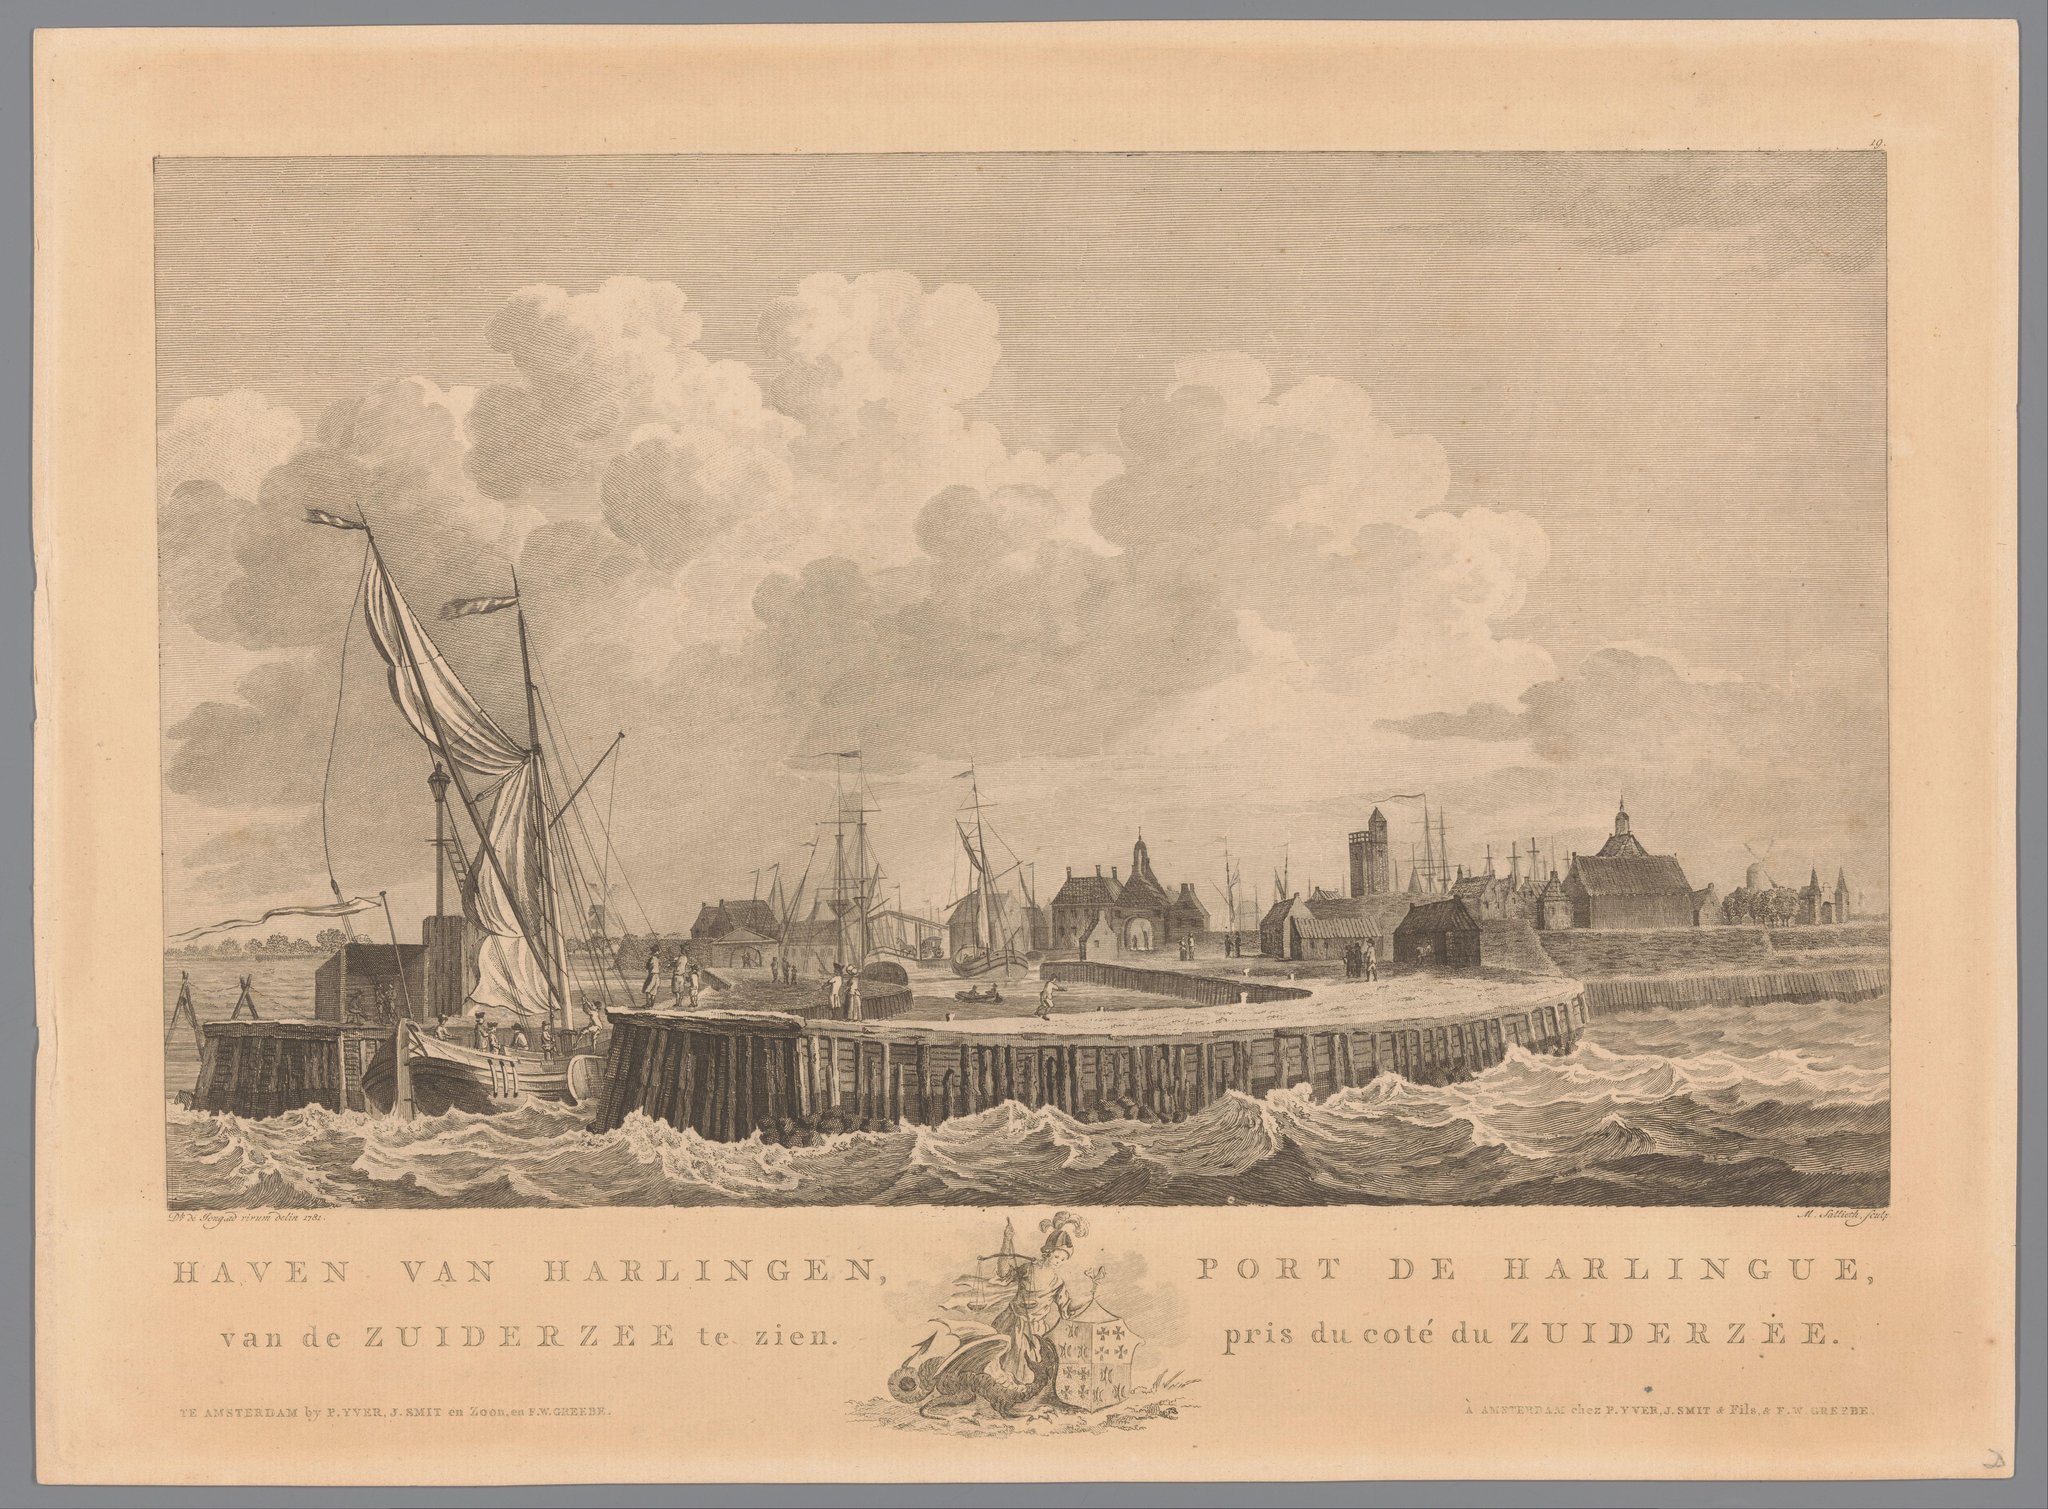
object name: print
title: Haven van Harlingen van de Zuiderzee te zien / Port de Harlingue, pris de coté du Zuiderzee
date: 1781-1787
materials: paper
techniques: etching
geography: amsterdam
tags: harbour, coat of arms (as symbol of the state, etc.) (+ city; municipal), sailing-ship, sailing-boat, harlingen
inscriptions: collector's mark: Lugt 2228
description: De haven van Harlingen, gezien vanaf de Zuiderzee. In de marge het wapen van de stad. Prent rechtsboven genummerd: 19.